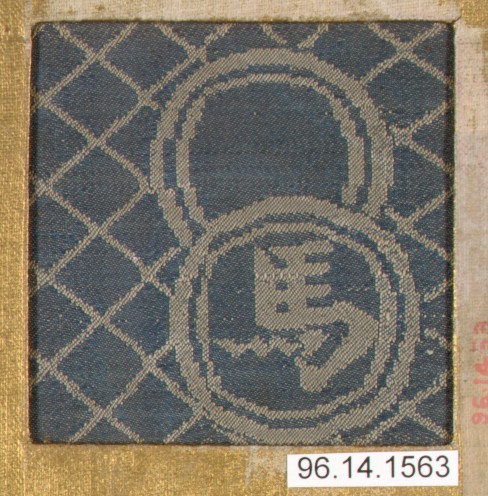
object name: piece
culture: japanese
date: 1701-1900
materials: silk